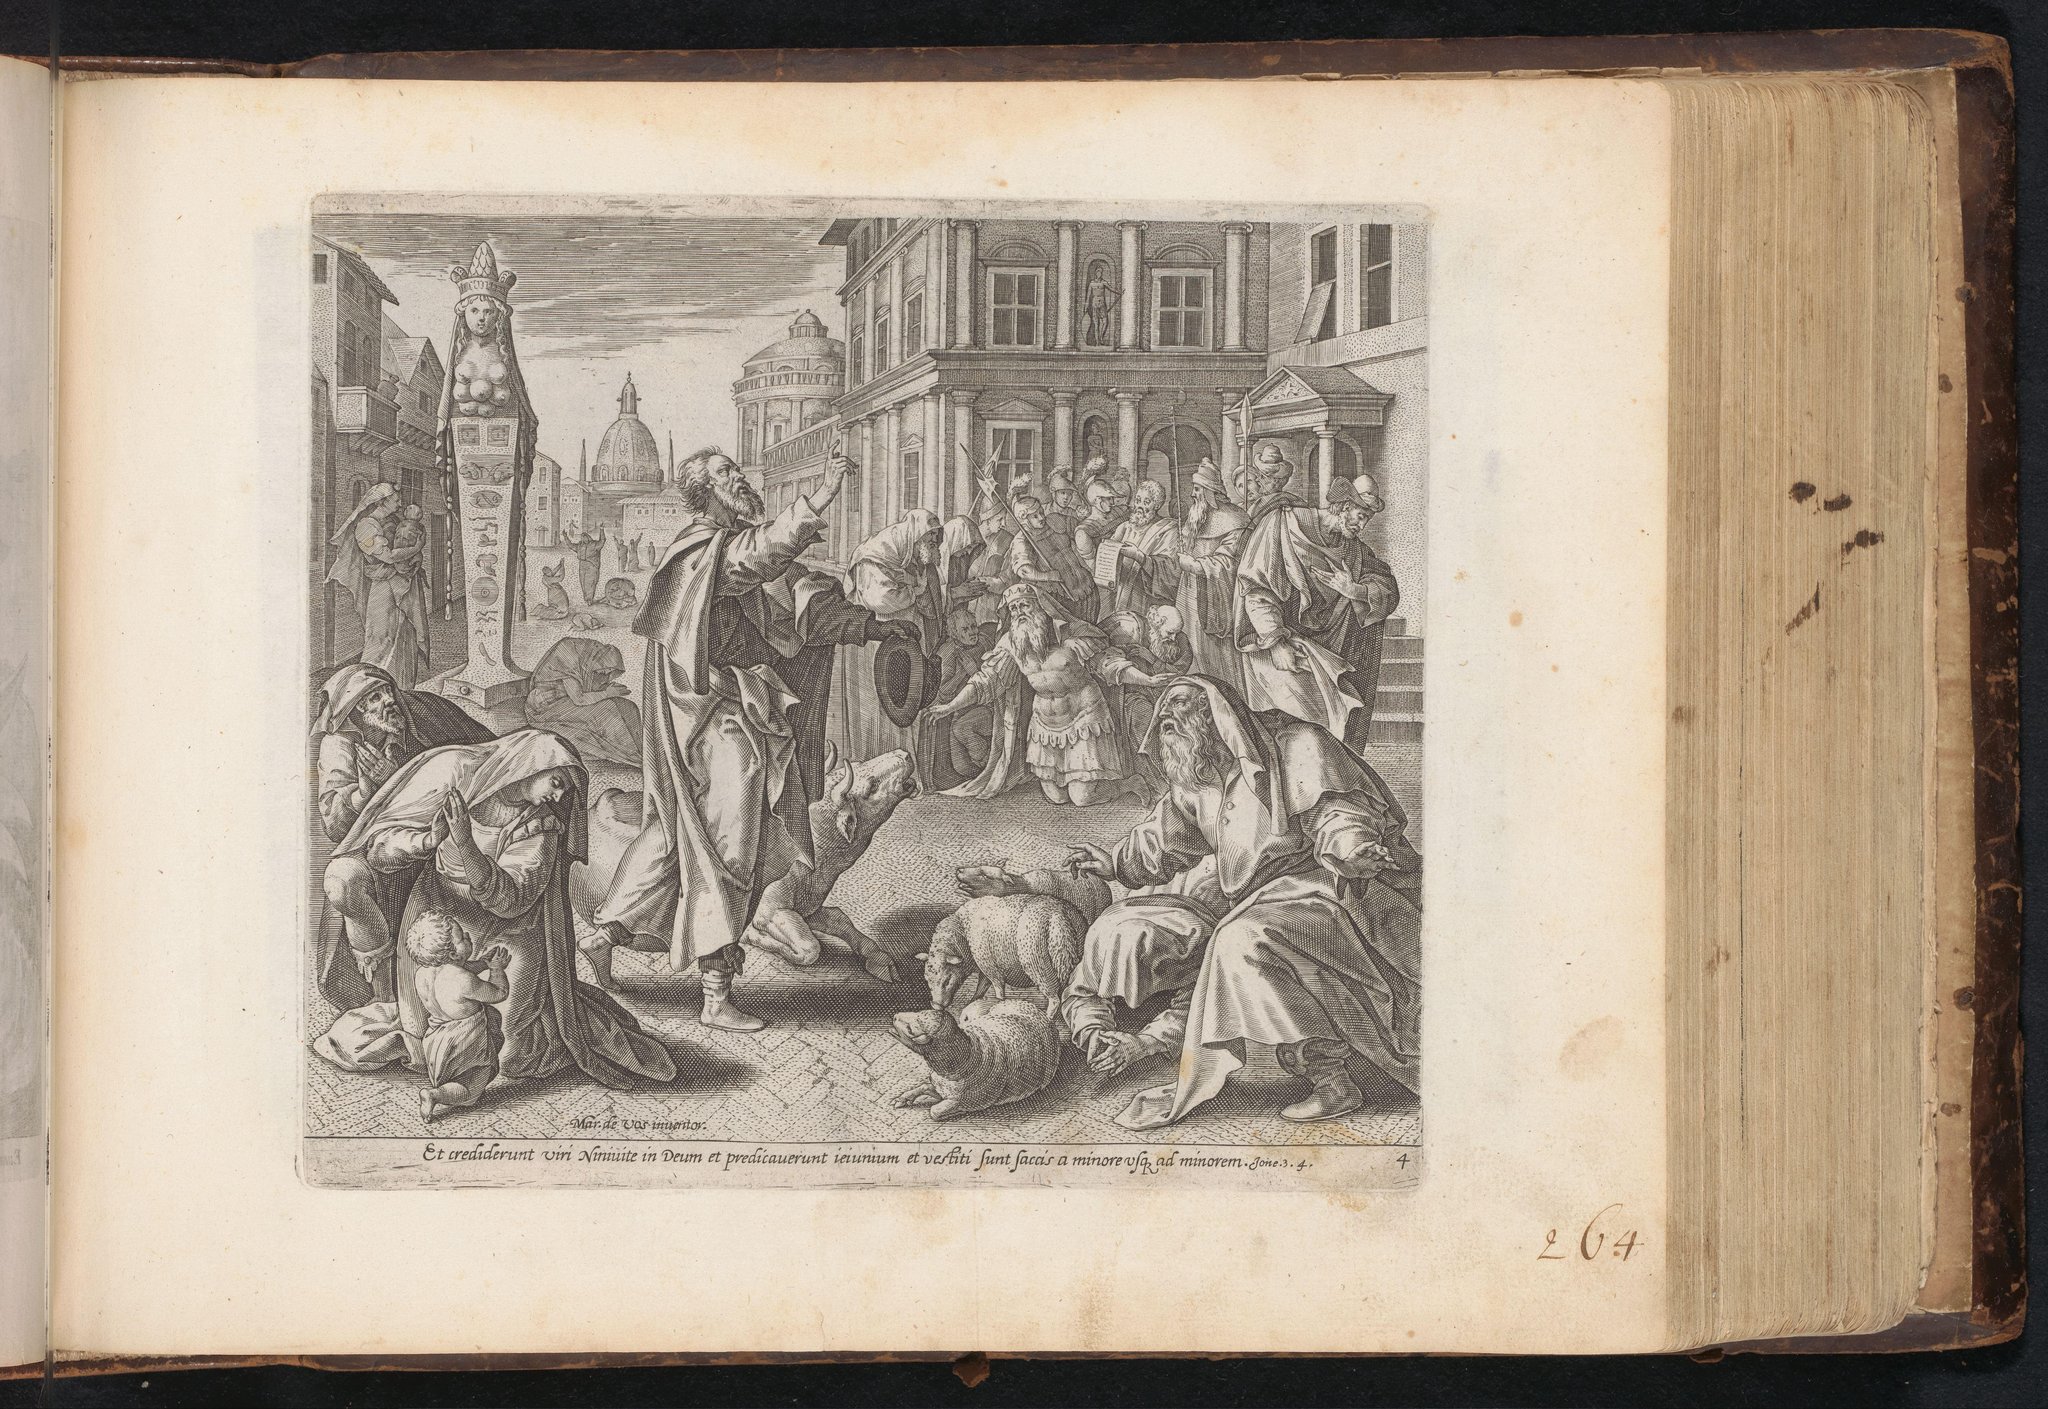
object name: album leaf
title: Van den Propheet Ionas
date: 1570-1612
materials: paper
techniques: engraving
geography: alkmaar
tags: when the king of nineveh hears about the destruction of the city in forty days, he rises from his throne and decrees a general repentance for man and animal: all men, cattle and sheep must fast, people must wear sackcloth and pray to god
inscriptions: number: ‘264’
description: Jona bewandelt de straten van Nineve en verkondigt de ondergang van de stad vanwege afgoderij. De inwoners en de dieren van Nineve knielen op de grond en smeken God berouwvol om vergiffenis. Ook de koning werpt zich op de grond. Onder de voorstelling een verwijzing in het Latijn naar de Bijbeltekst in Jona 3:4. Deze prent maakt deel uit van een album.